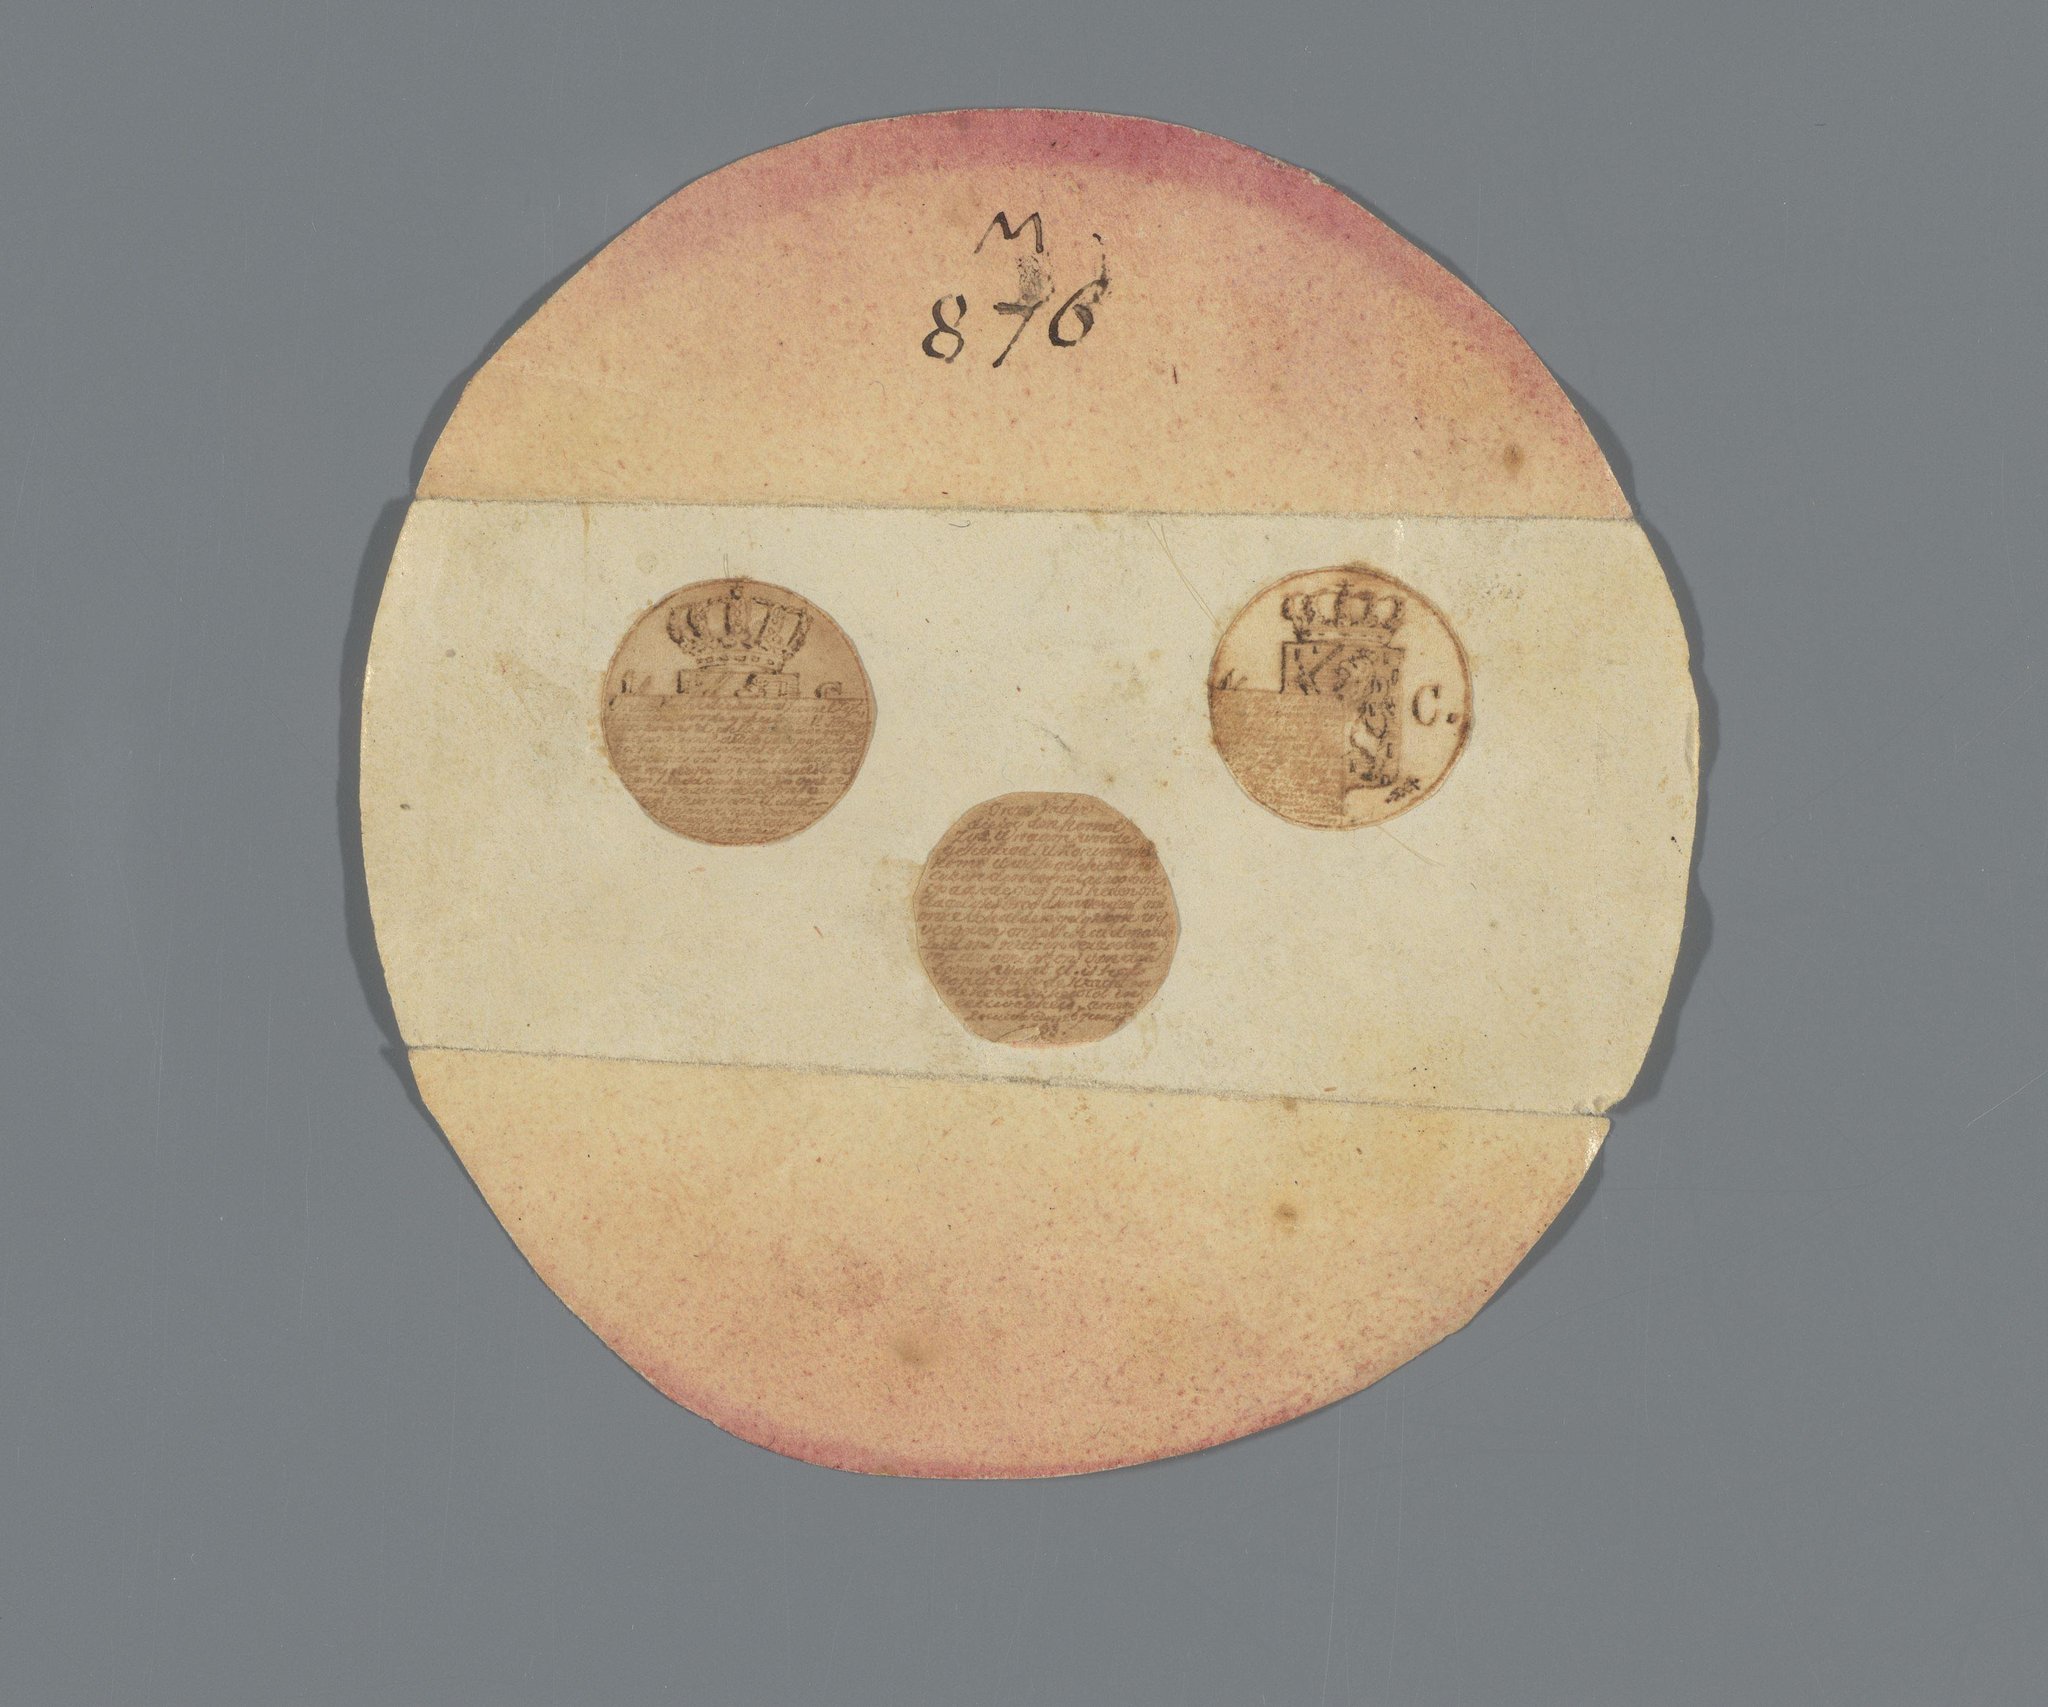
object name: letter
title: Briefje met getekende centen waarin het Onze Vader is geschreven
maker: lambertus ekkelboom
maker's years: 1850-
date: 1850-1950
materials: paper, wood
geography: leeuwarden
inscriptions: inscription: ‘Vervaardigd door de Hr. Lambertus Ekkelboom te Leeuwarden, ten geschenken gegeven door de Hr. J.H. van IJssel, predikant te Hempens bij Leeuwarden.’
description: Rond briefje met drie getekende centen (een hele, een halve en een vierde cent) met opschrift op de achterkant.